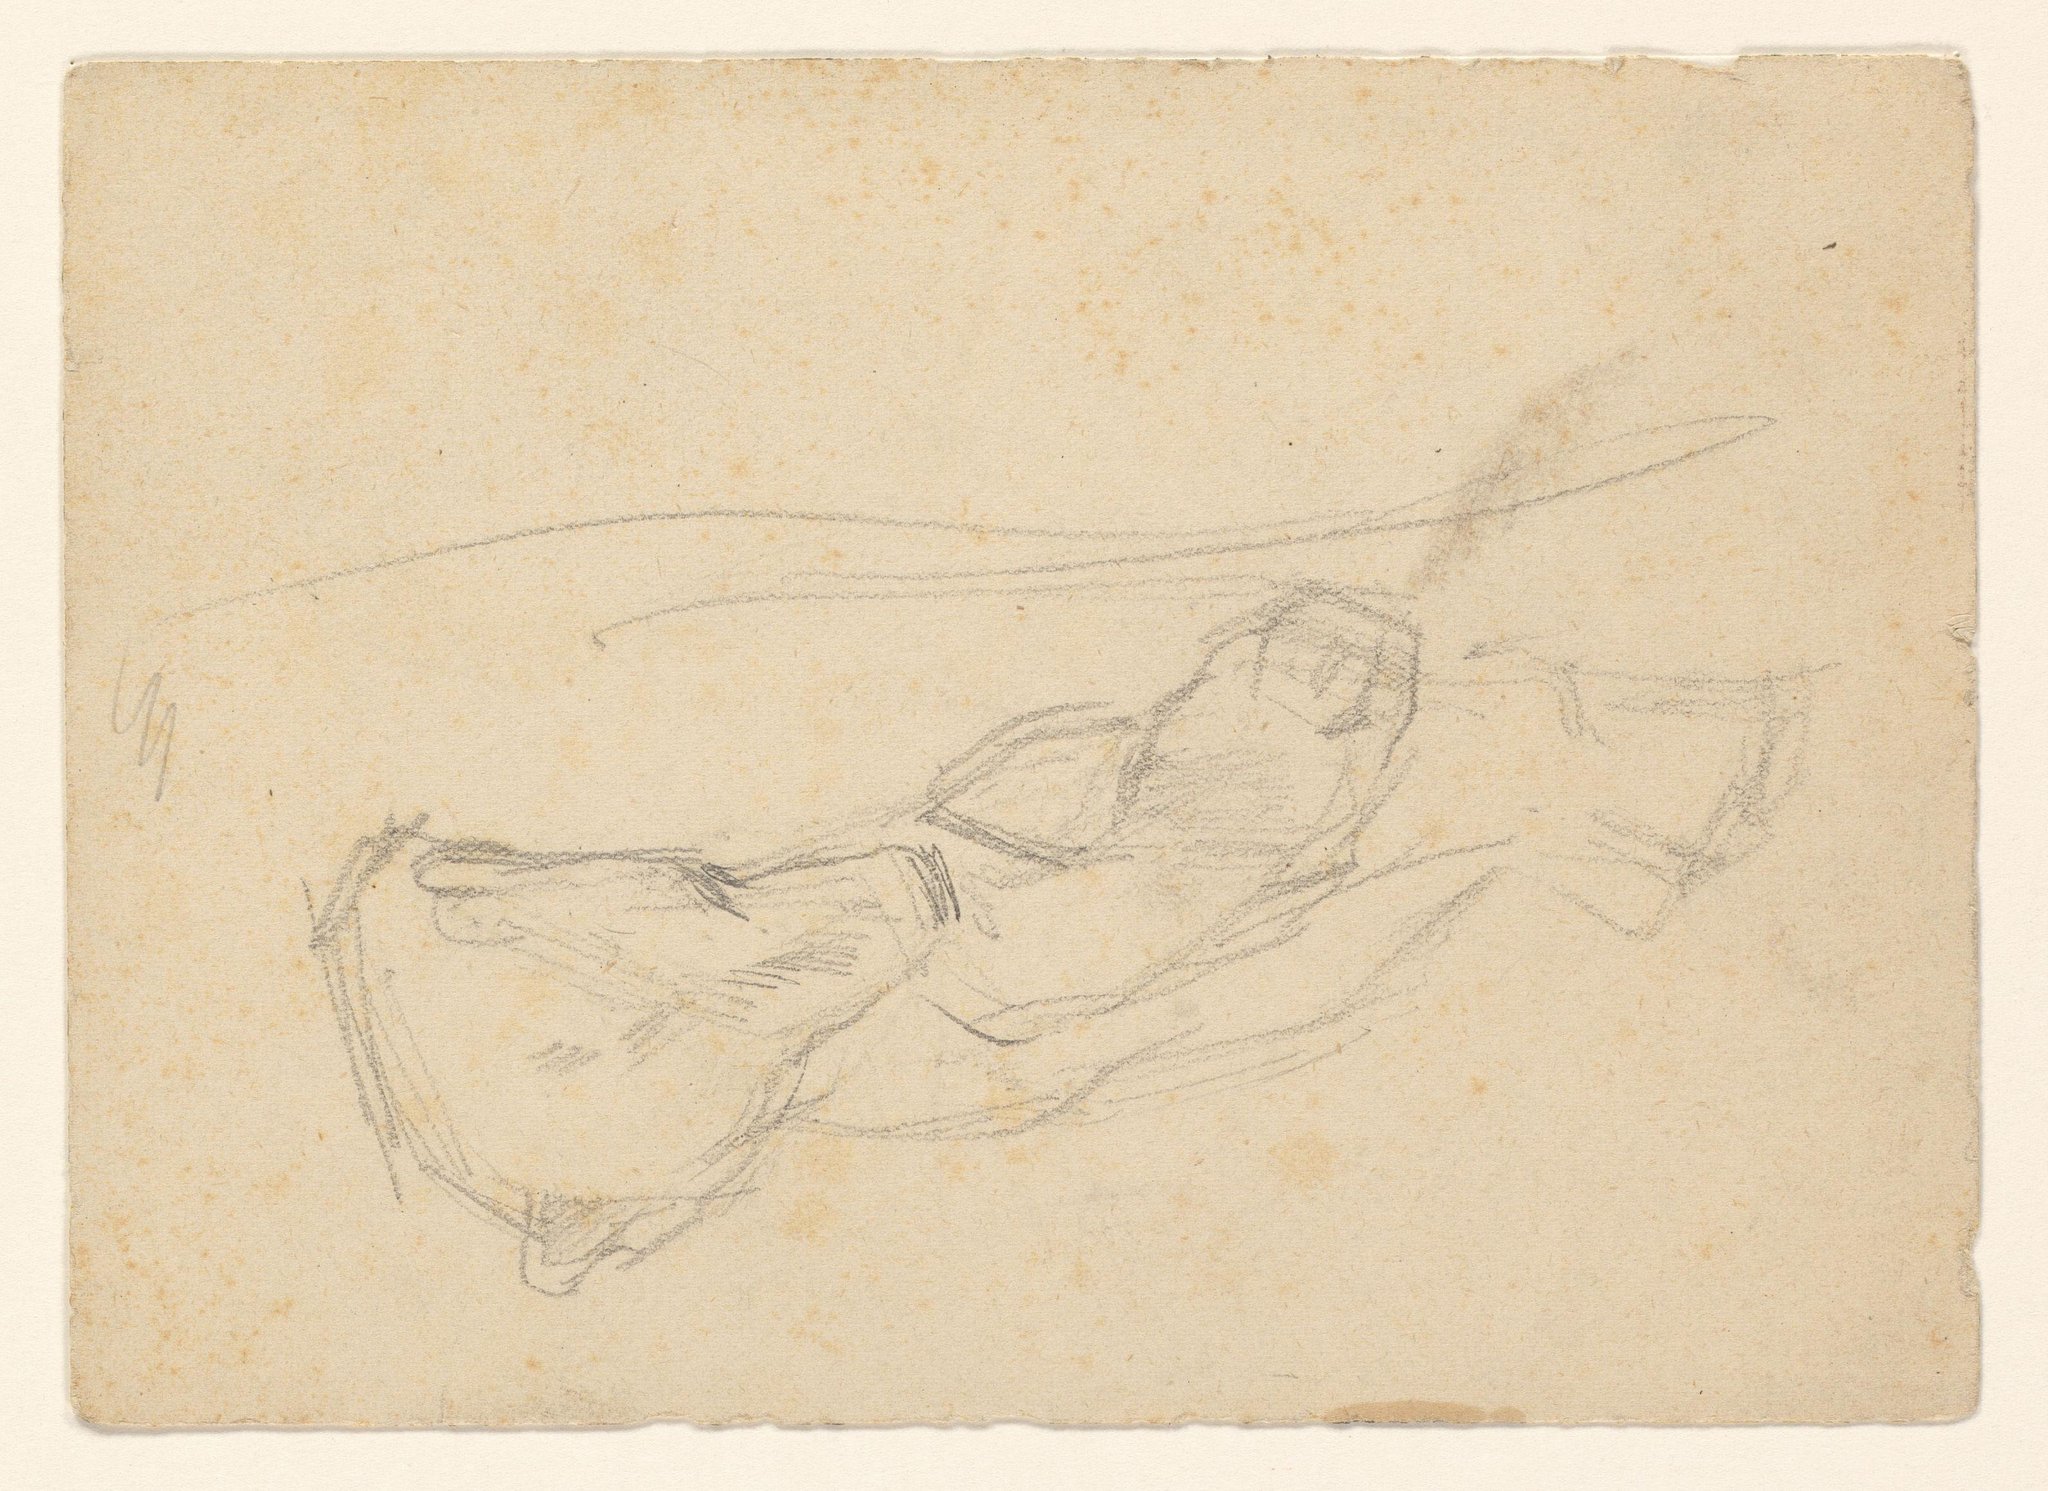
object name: drawing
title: Schetsblad met slapende ijsbeer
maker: august allebé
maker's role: draughtsman, print maker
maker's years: 1838-1927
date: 1848-1927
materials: paper, pencil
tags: beasts of prey, predatory animals: polar bear